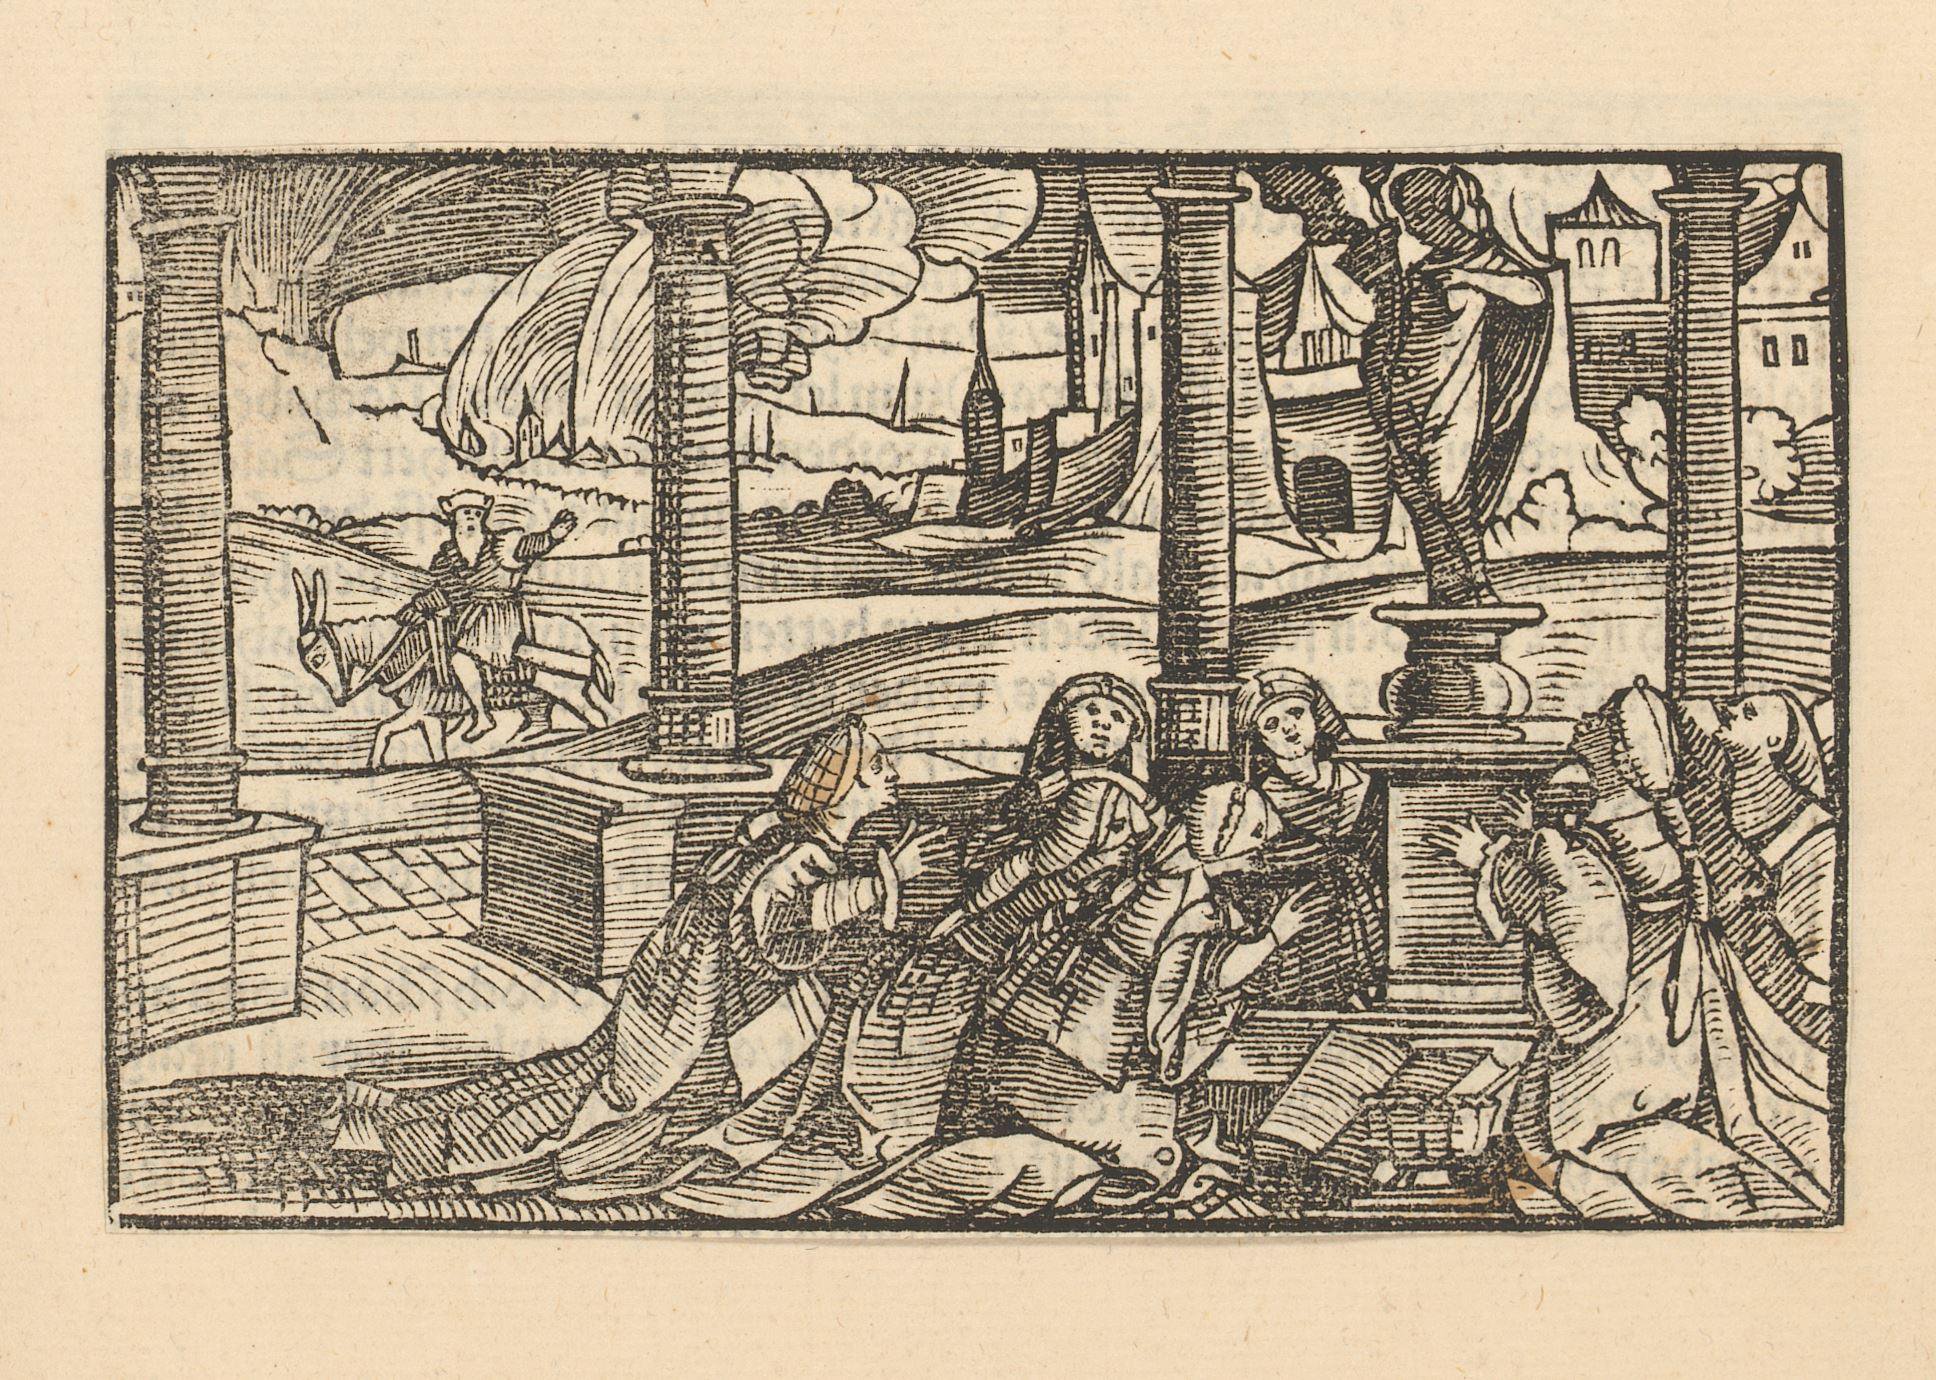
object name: album leaf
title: Vrouwen aanbidden een beeld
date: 1490-1537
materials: paper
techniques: letterpress printing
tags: heresy; 'heresia' (ripa)